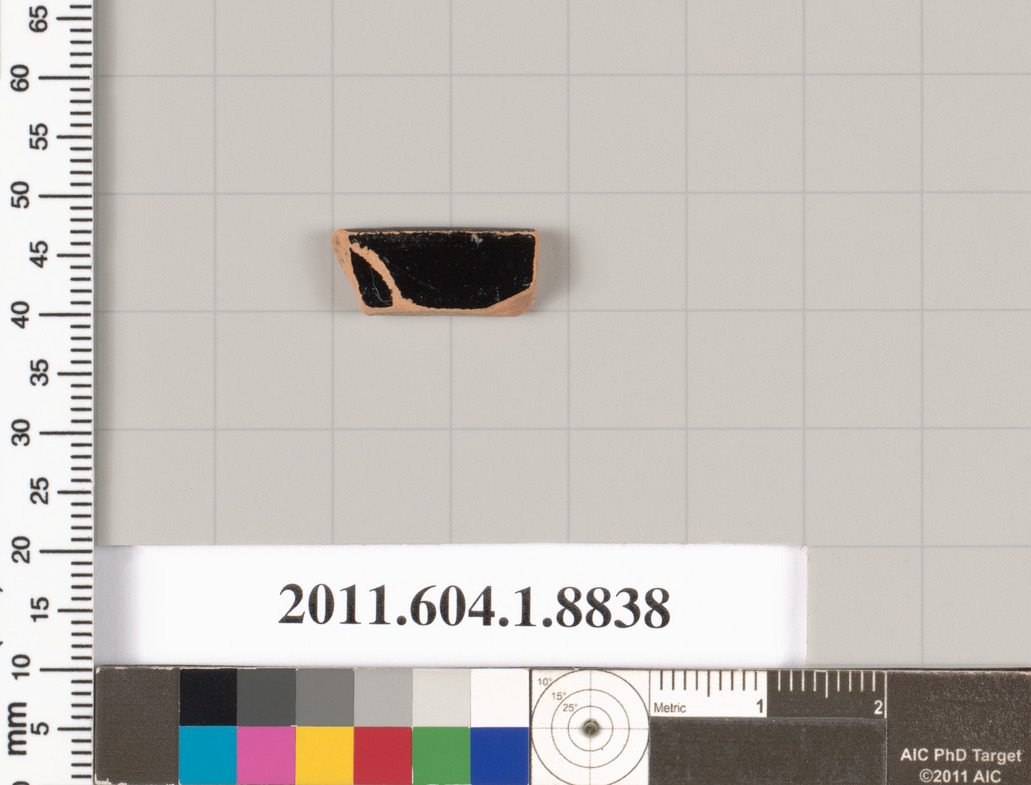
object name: kylix fragment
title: Terracotta rim fragment of a kylix (drinking cup)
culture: greek, attic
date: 480-460 BCE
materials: terracotta